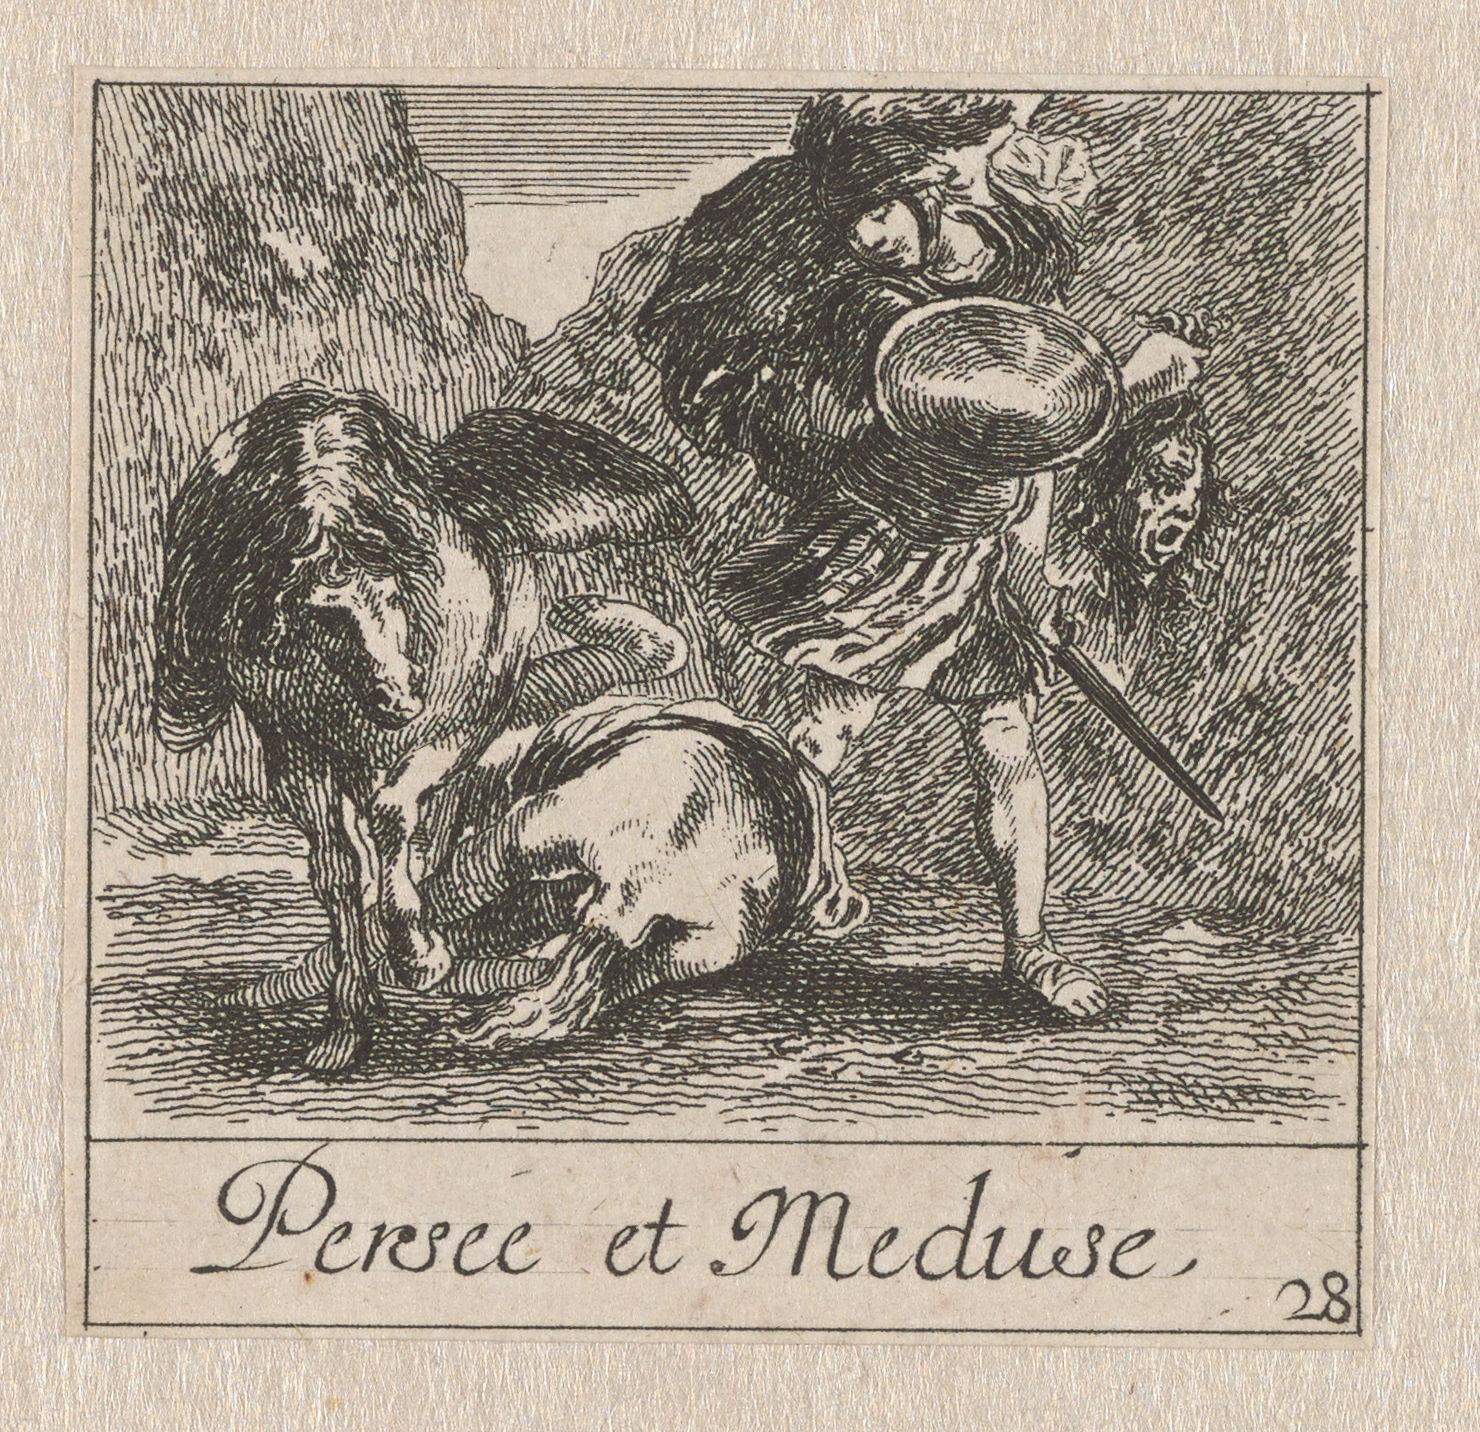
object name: playing card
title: Perseus en Medusa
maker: Anonymous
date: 1620-1664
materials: paper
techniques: etching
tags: perseus beheading medusa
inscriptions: collector's mark: Lugt 240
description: Prent uit een reeks van 54 genummerde speelkaarten met voorstellingen uit de Metamorfosen van Ovidius.